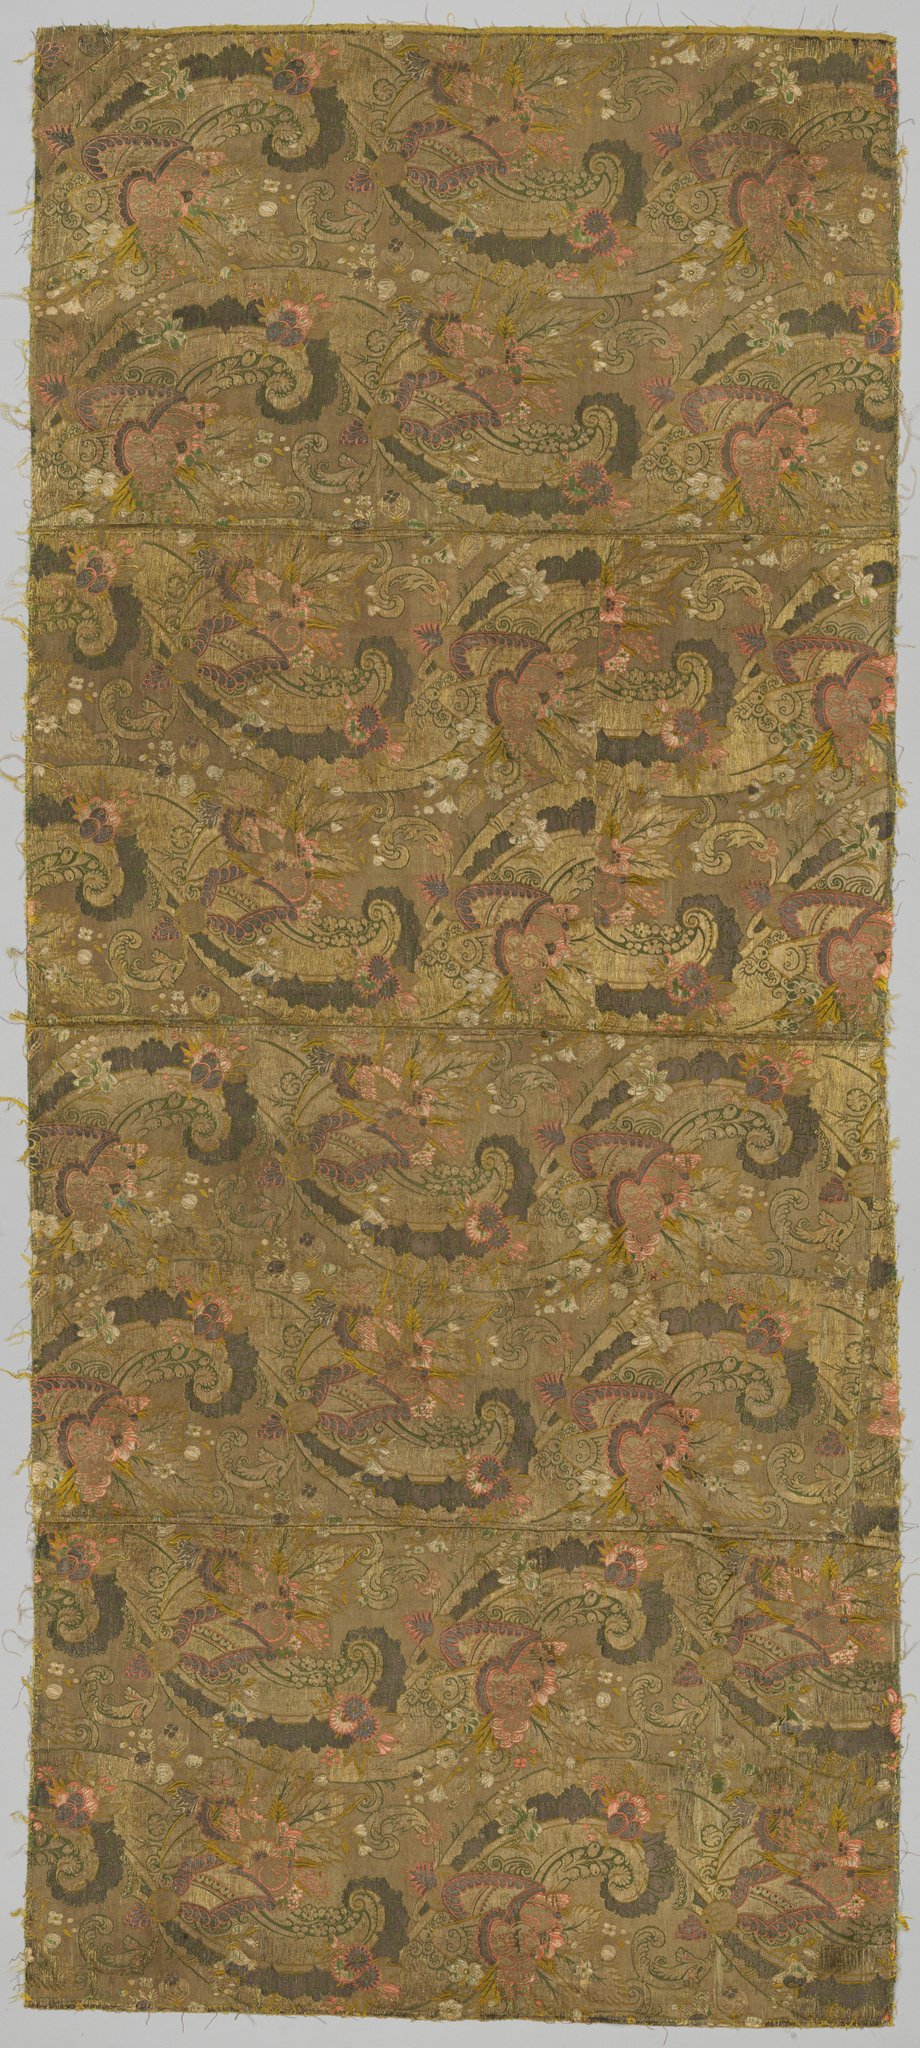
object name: silk textile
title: Veelkleurig zijdeweefsel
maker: Anonymous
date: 1715-1720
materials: silk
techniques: brocade, weave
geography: england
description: Zes aan elkaar gezette fragmenten veelkleurig zijdeweefsel. Het patroon heeft voluten, acanthusbladeren en bloemen.